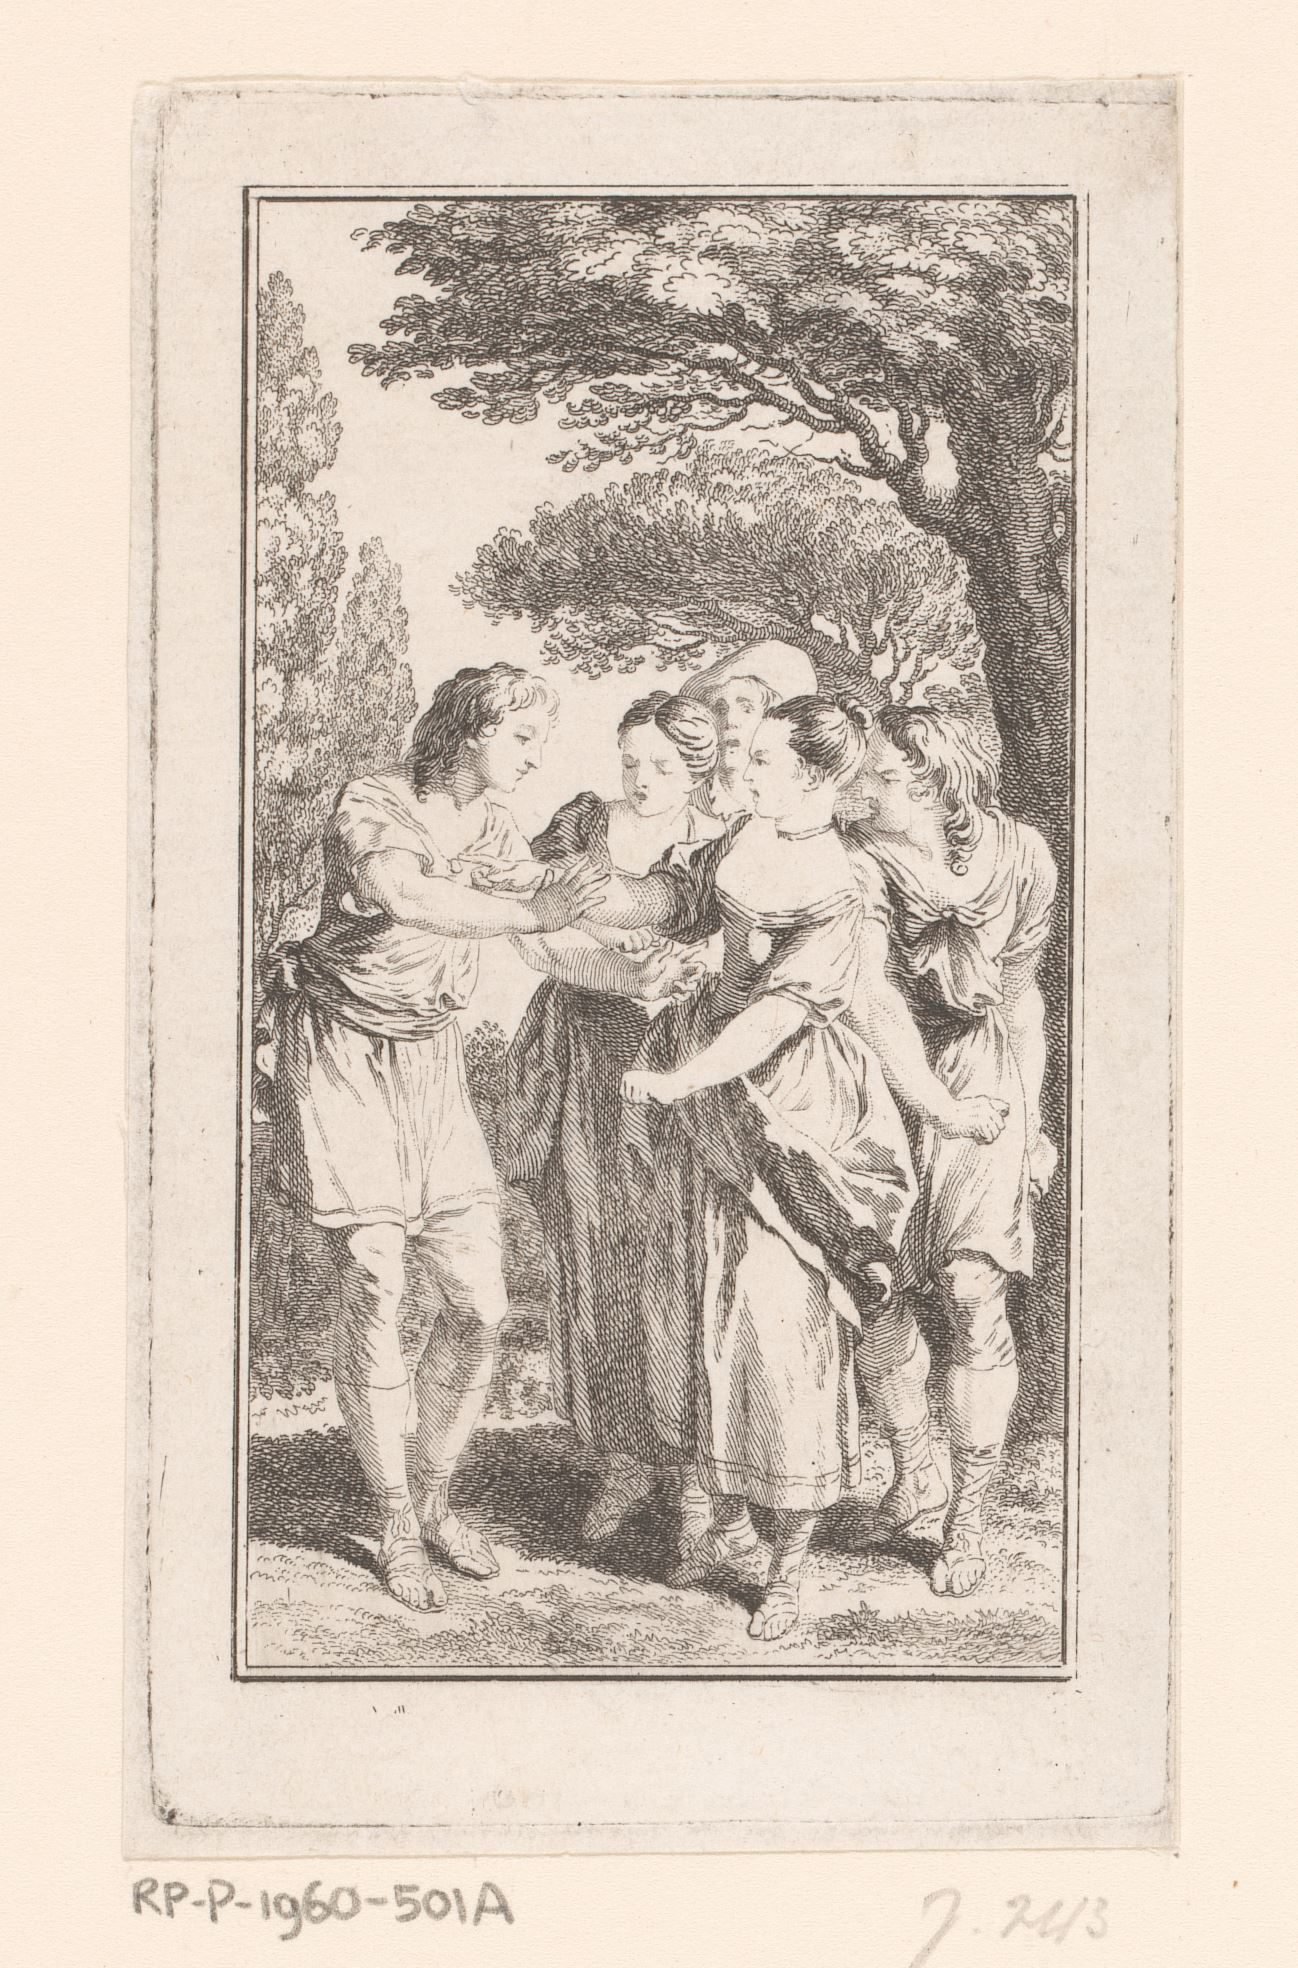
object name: print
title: Wedstrijd van Tempé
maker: dominique sornique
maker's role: print maker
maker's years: 1707-1756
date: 1734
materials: paper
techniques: engraving, etching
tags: musical drama, performance of musical drama, pastorals, arcadian scenes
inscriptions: collector's mark: Lugt 2228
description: Prent uit: Rameau, Jean-Philippe. Les courses de Tempé, pastorale avec un divertissement. S.l.s.n., 1734, afb. voor p. 433.